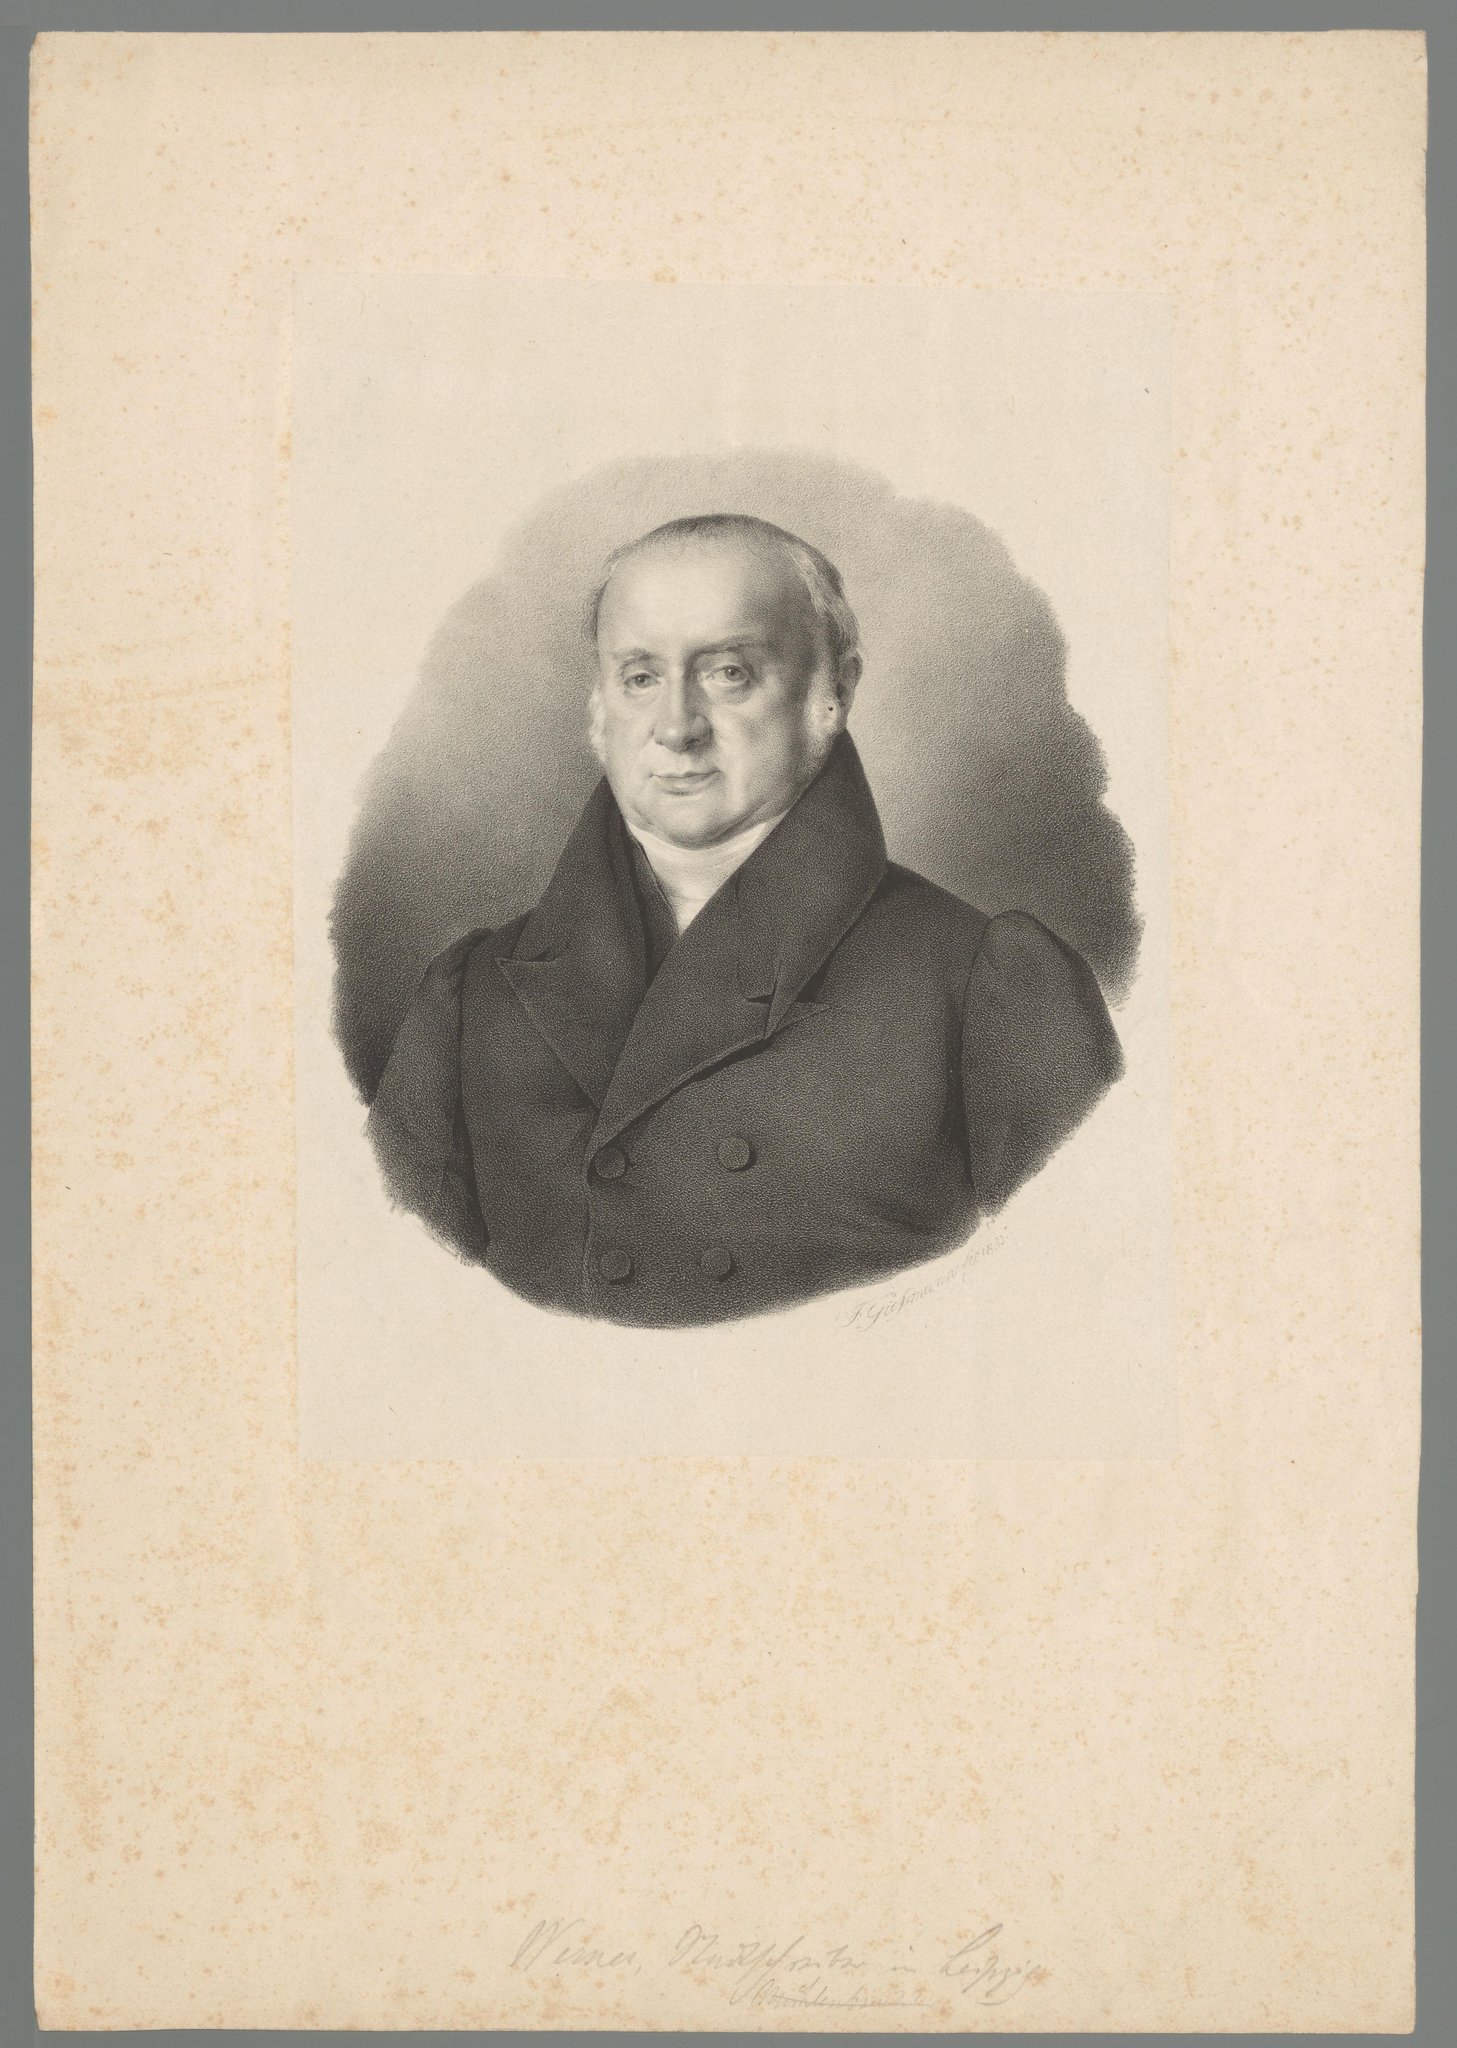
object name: print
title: Portret van een onbekende man, mogelijk Werner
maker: friedrich giessmann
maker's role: print maker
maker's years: 1810-1847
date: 1833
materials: paper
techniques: lithograph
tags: adult man, historical persons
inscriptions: collector's mark: Lugt 2228